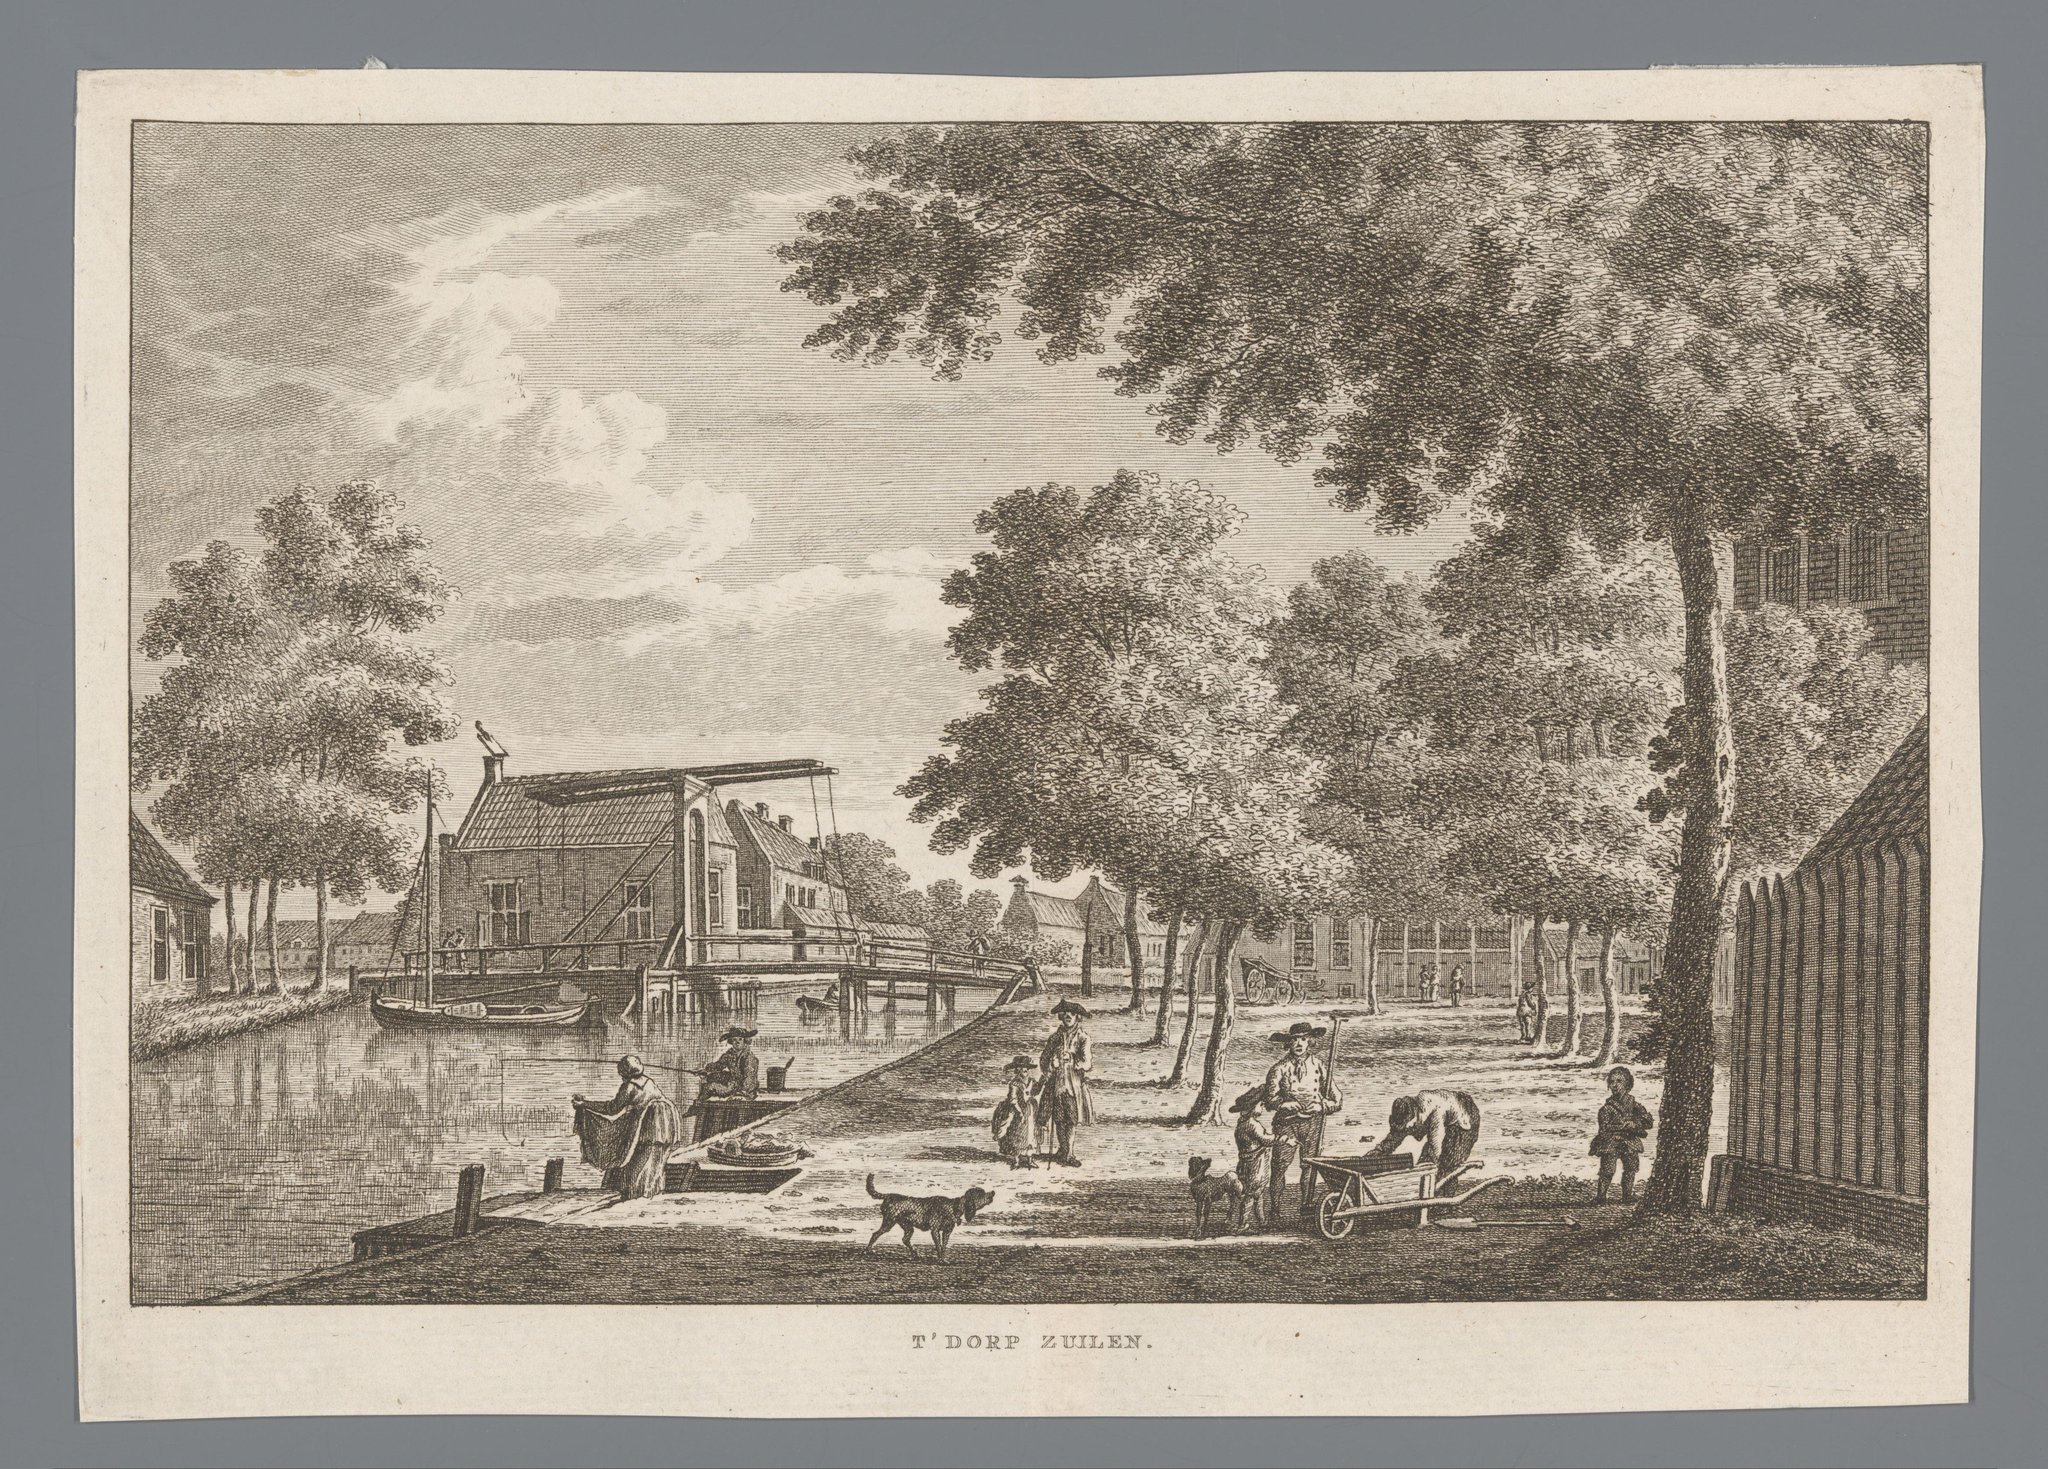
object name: print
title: t' Dorp Zuilen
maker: carel frederik bendorp (i)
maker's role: print maker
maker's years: 1736-1814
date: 1786-1792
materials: paper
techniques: engraving, etching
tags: bascule bridge, bridge in village across river, canal, etc.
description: Prent uit: Vaderlandsche gezichten, of afbeeldingen van den tegenwoordigen staat der Vereenigde Nederlanden (…). Amsterdam: Hendrik Gartman, Willem Vermandel en Jan Willem Smit, 1786-1792. Uitgegeven in afleveringen met ieder een eigen bifolium en inhoudsopgave. Alle prenten in deze publicatie zijn gegraveerd door Carel Frederik Bendorp (I) en, in de meeste gevallen, gebaseerd op tekeningen van Jan Bulthuis.